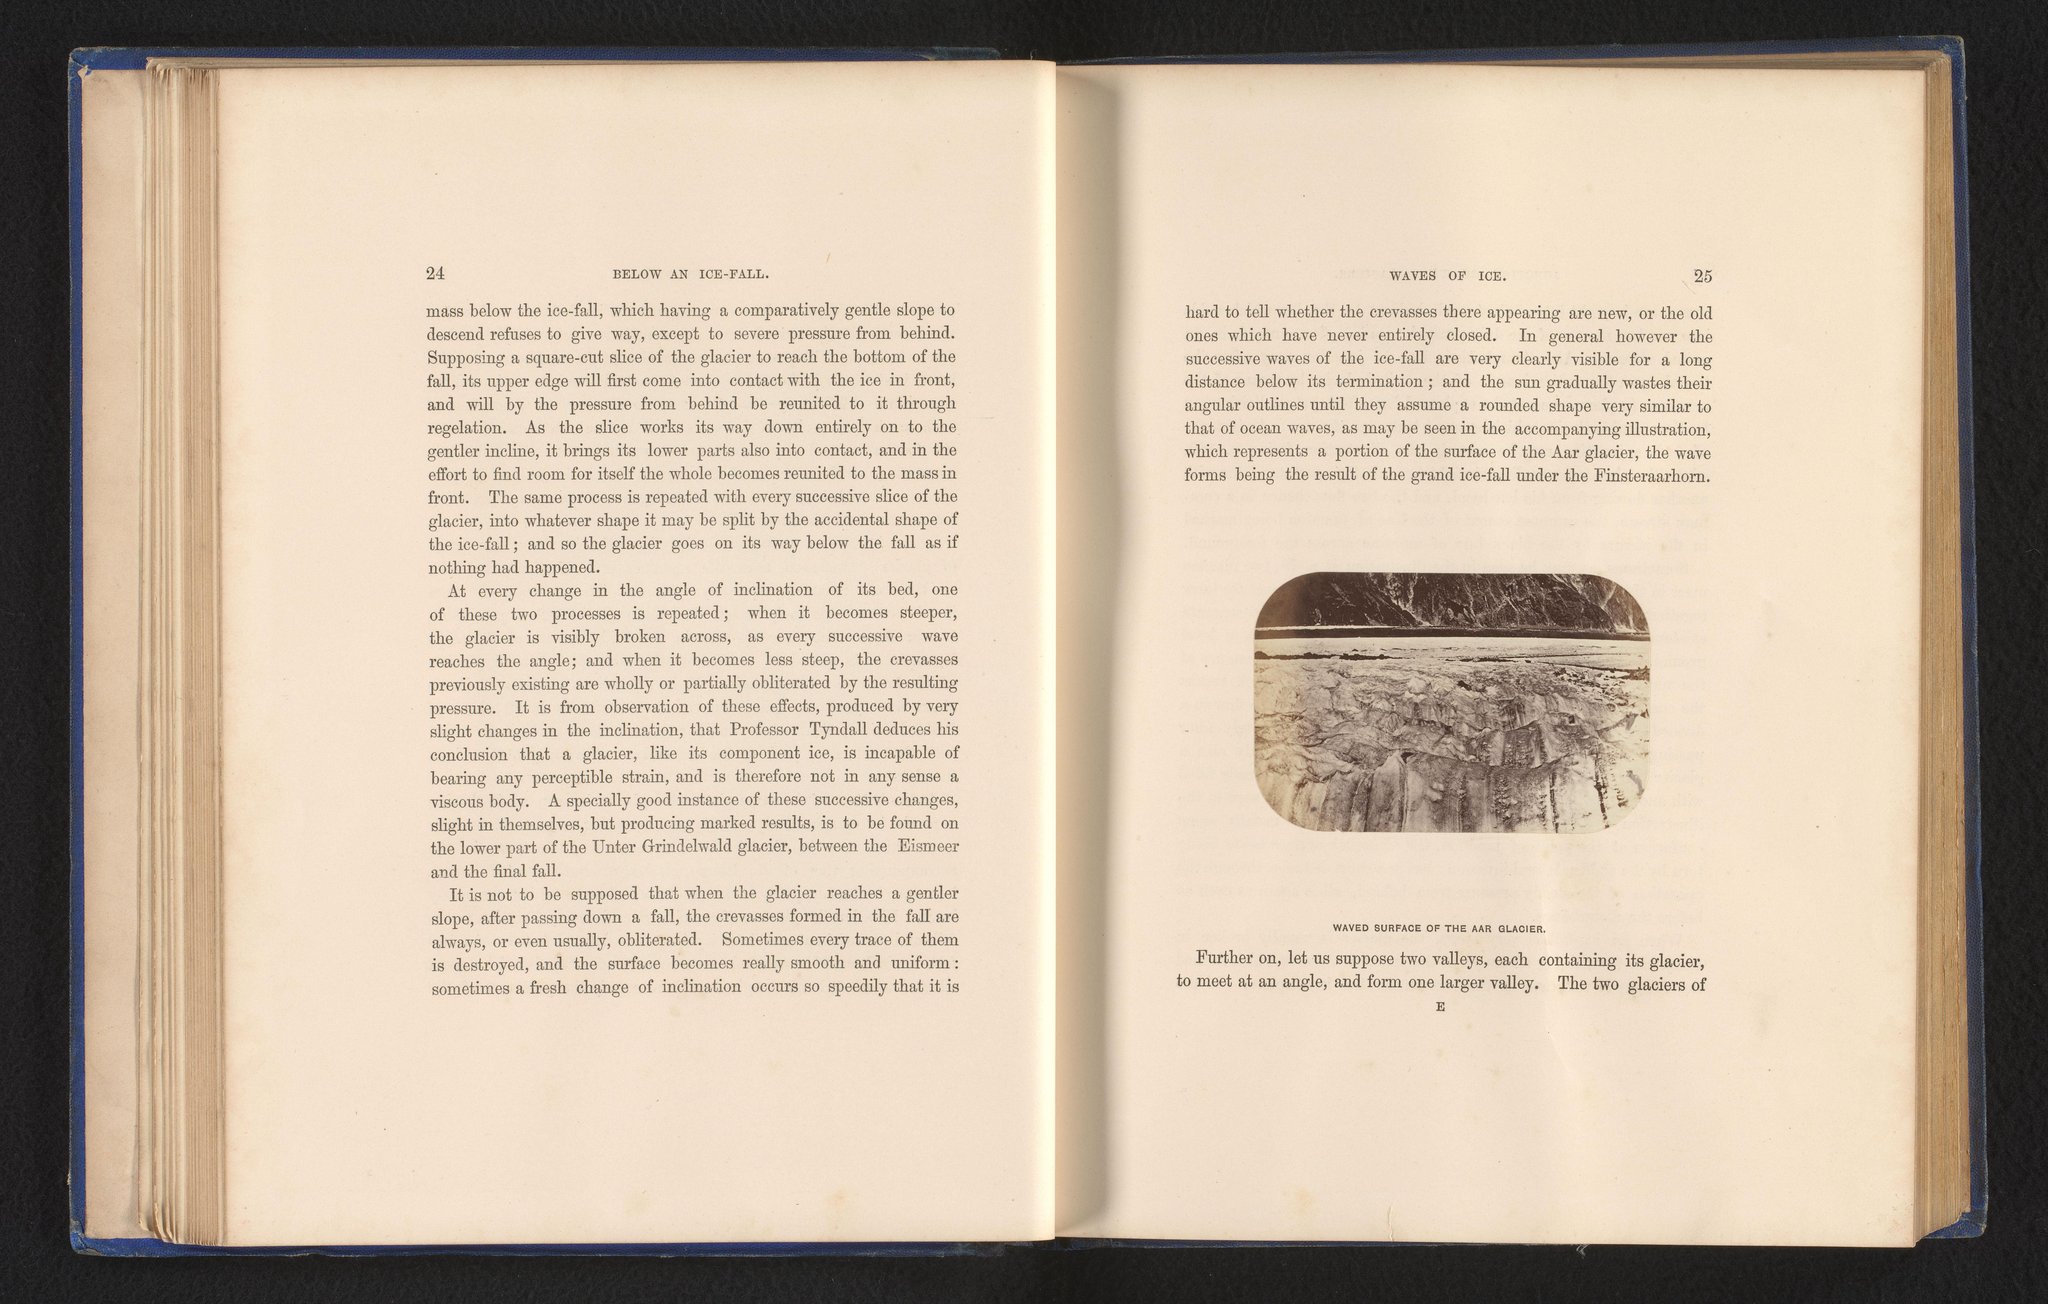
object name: photograph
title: Waved surface of the Aar glacier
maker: ernest edwards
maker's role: fotograaf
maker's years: 1837-1903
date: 1861-1866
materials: paper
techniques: albumen print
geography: berner oberland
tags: glacier